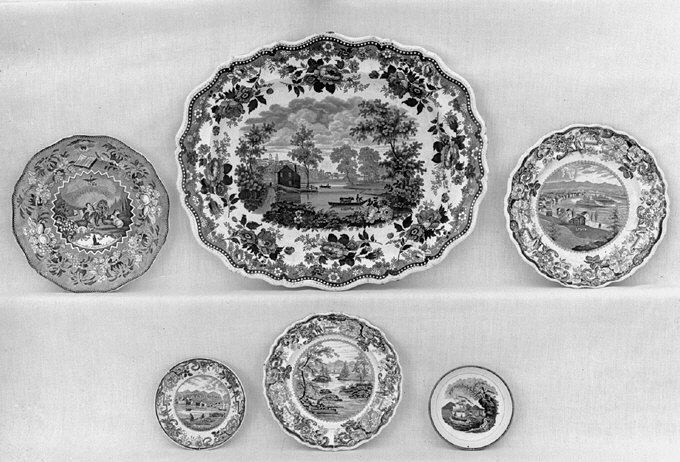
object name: plate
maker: j. & g. meakin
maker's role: factory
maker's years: 1851-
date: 1801-1900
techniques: printing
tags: houses,landscapes,trees,boats